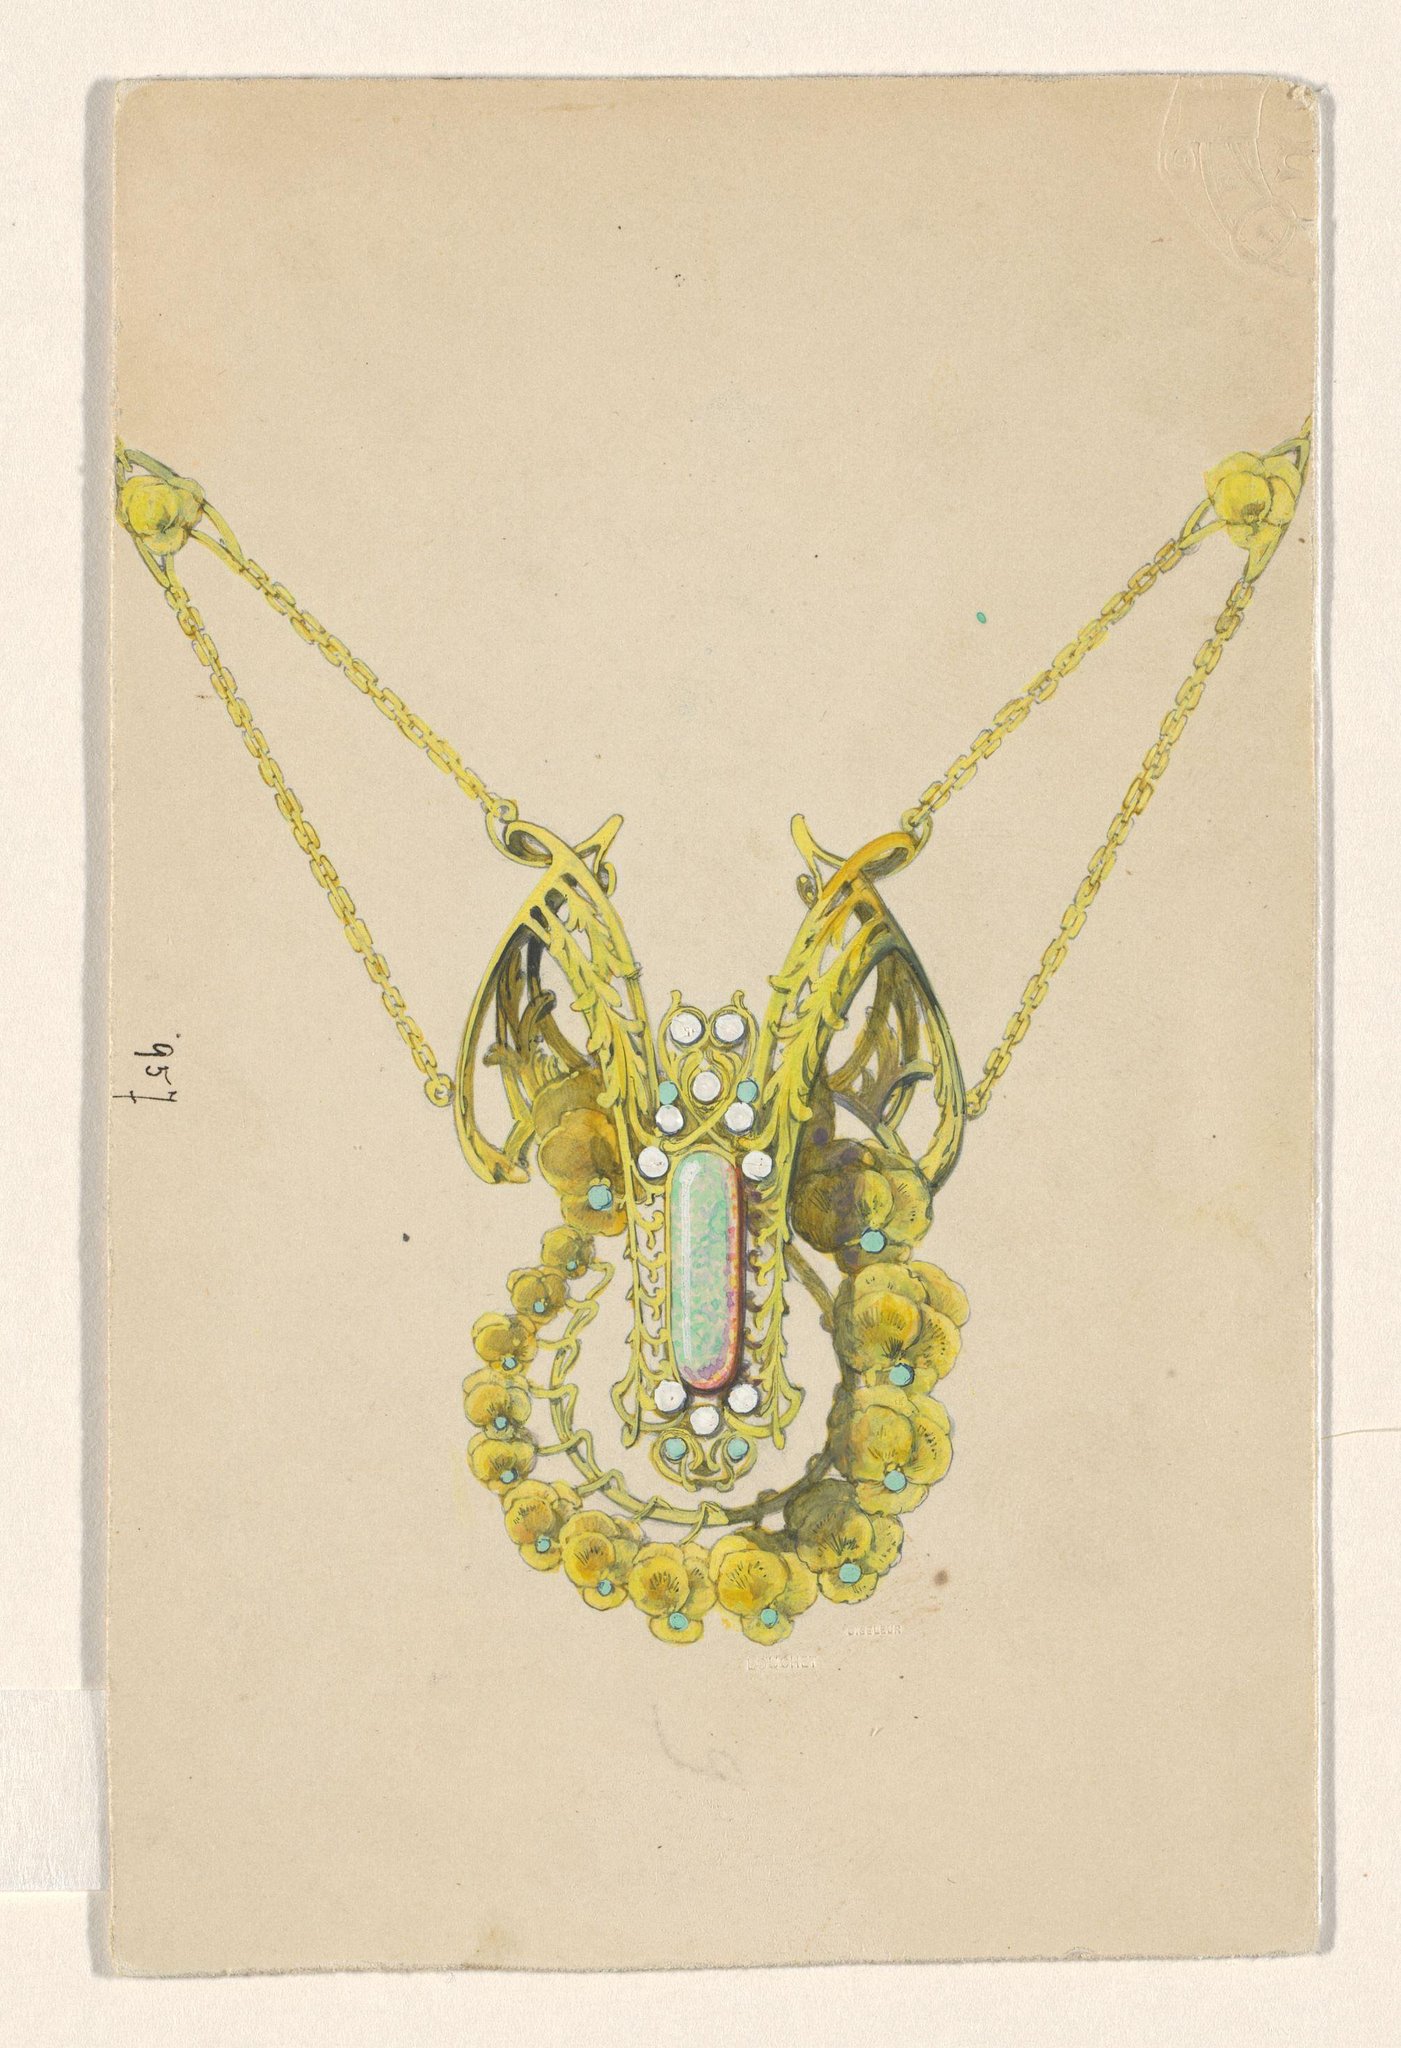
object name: design drawing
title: Ontwerp voor een hanger met viooltjes, van geëmailleerd goud met een opaal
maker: paul louchet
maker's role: painter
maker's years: 1854-1936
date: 1905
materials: ink, paper, watercolor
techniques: aquarelle, drawing, pen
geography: paris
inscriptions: inscription: ‘BRISTOL en AL’, number: ‘957’, name: ‘LOUCHET CISELEUR’